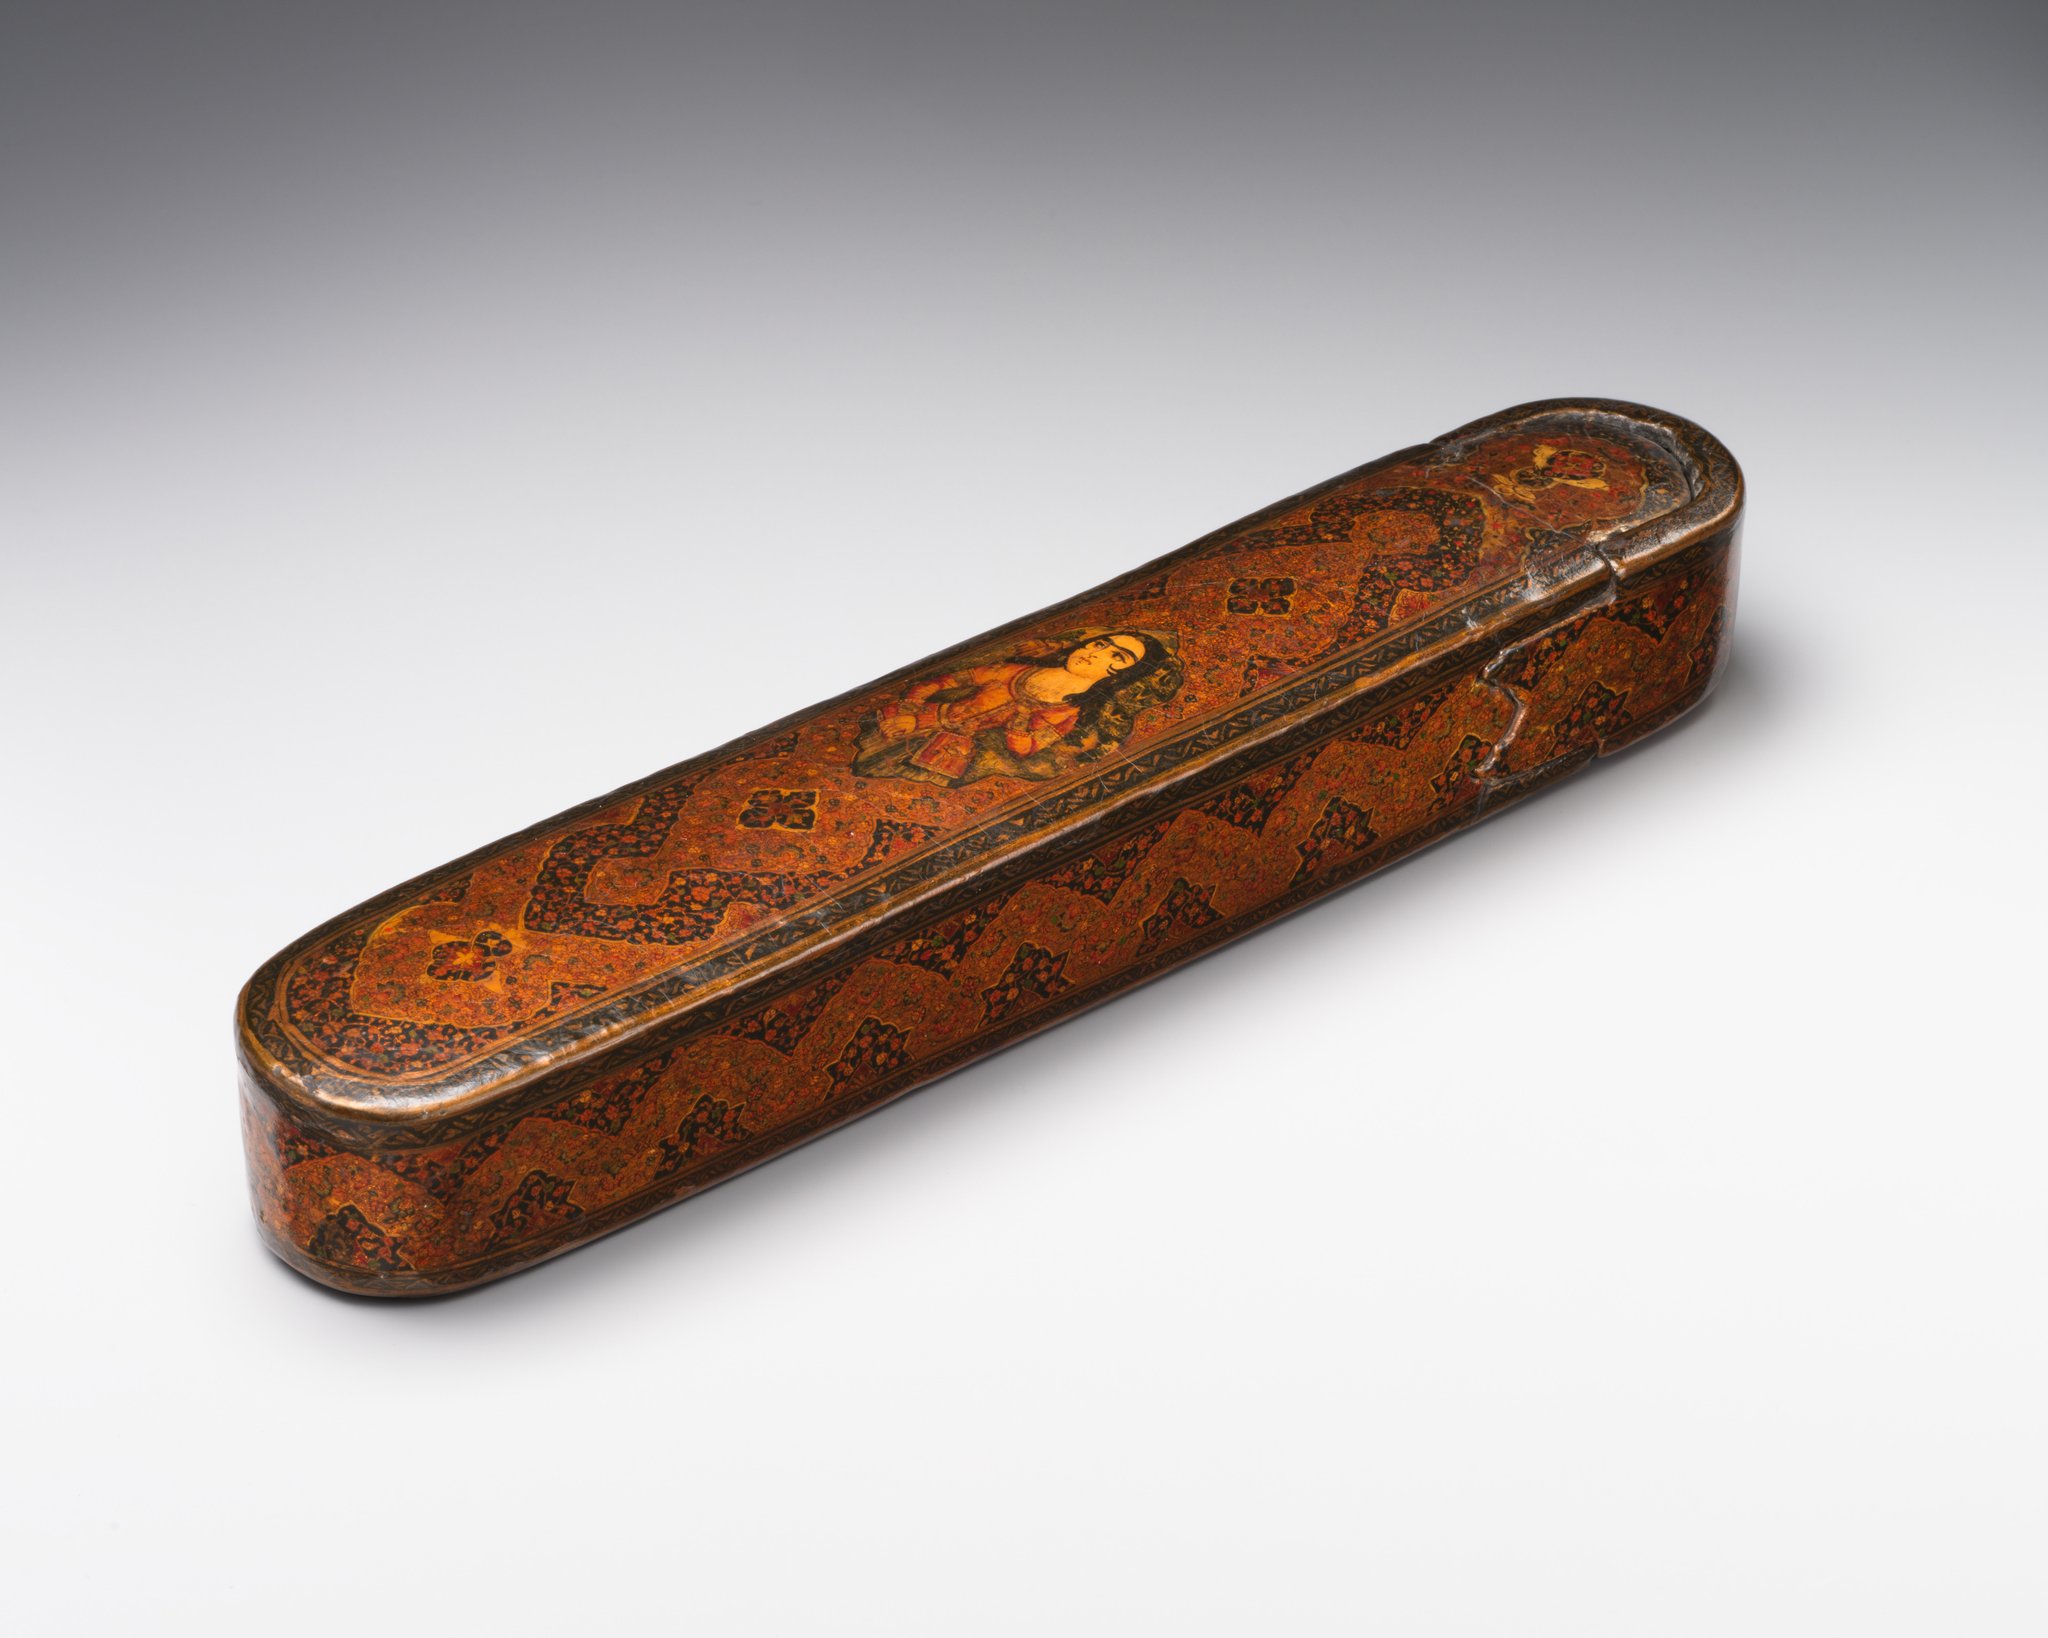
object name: pen box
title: Pen Box (Qalamdan)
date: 1701-1900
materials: paper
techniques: lacquer, painting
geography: iran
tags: women